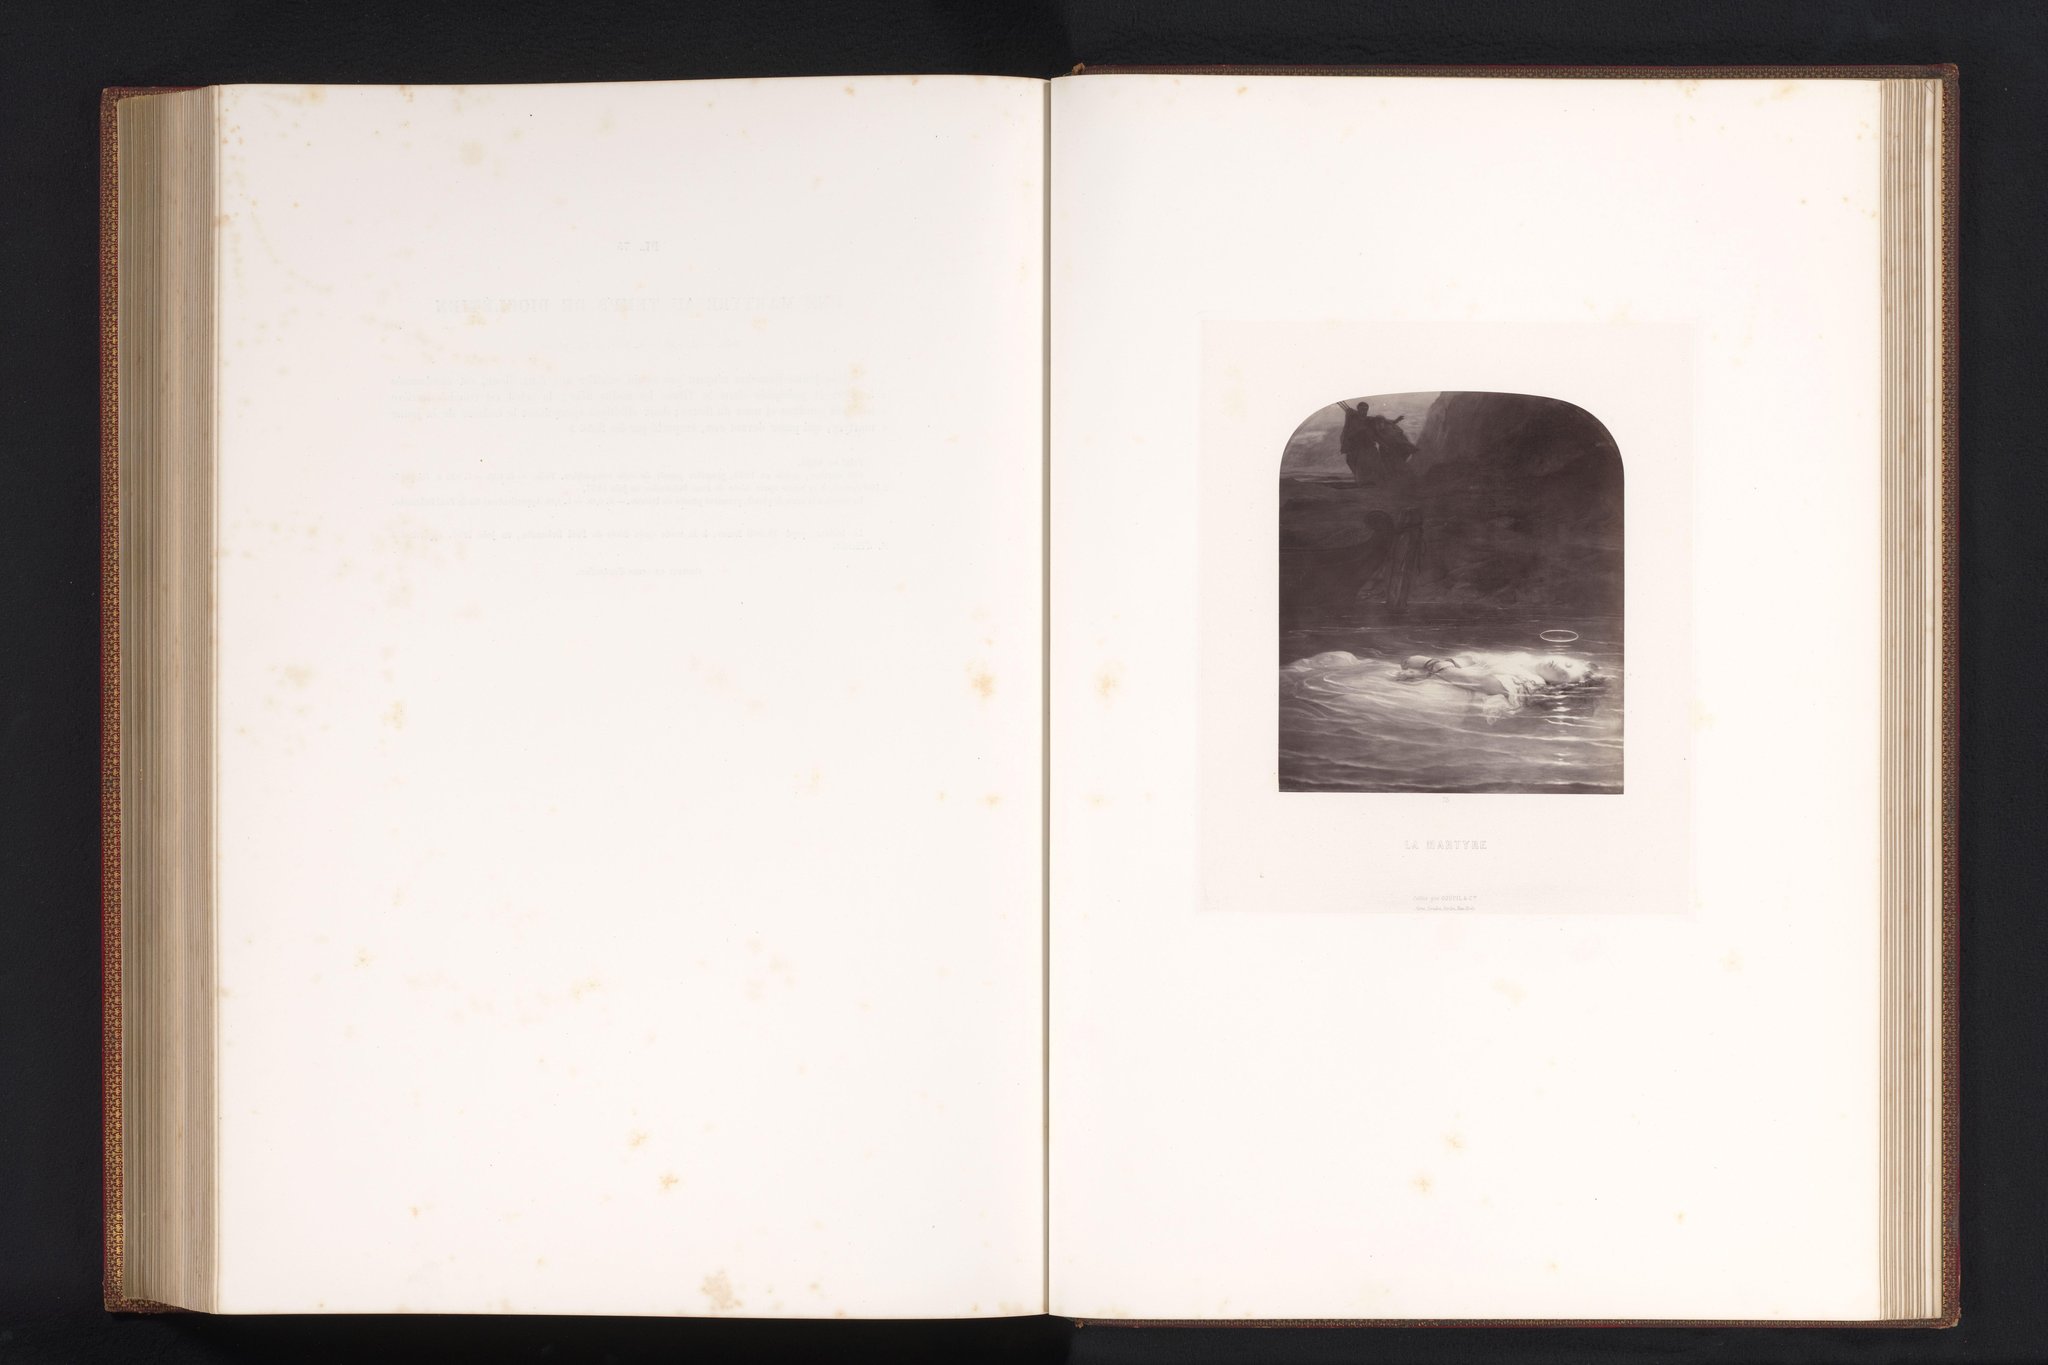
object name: photograph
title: Une martyre au temps de Dioclétien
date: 1855-1858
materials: paper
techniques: albumen print, engraving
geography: paris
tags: drowned person, female saints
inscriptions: check stamp: ‘Goupil & Cie’